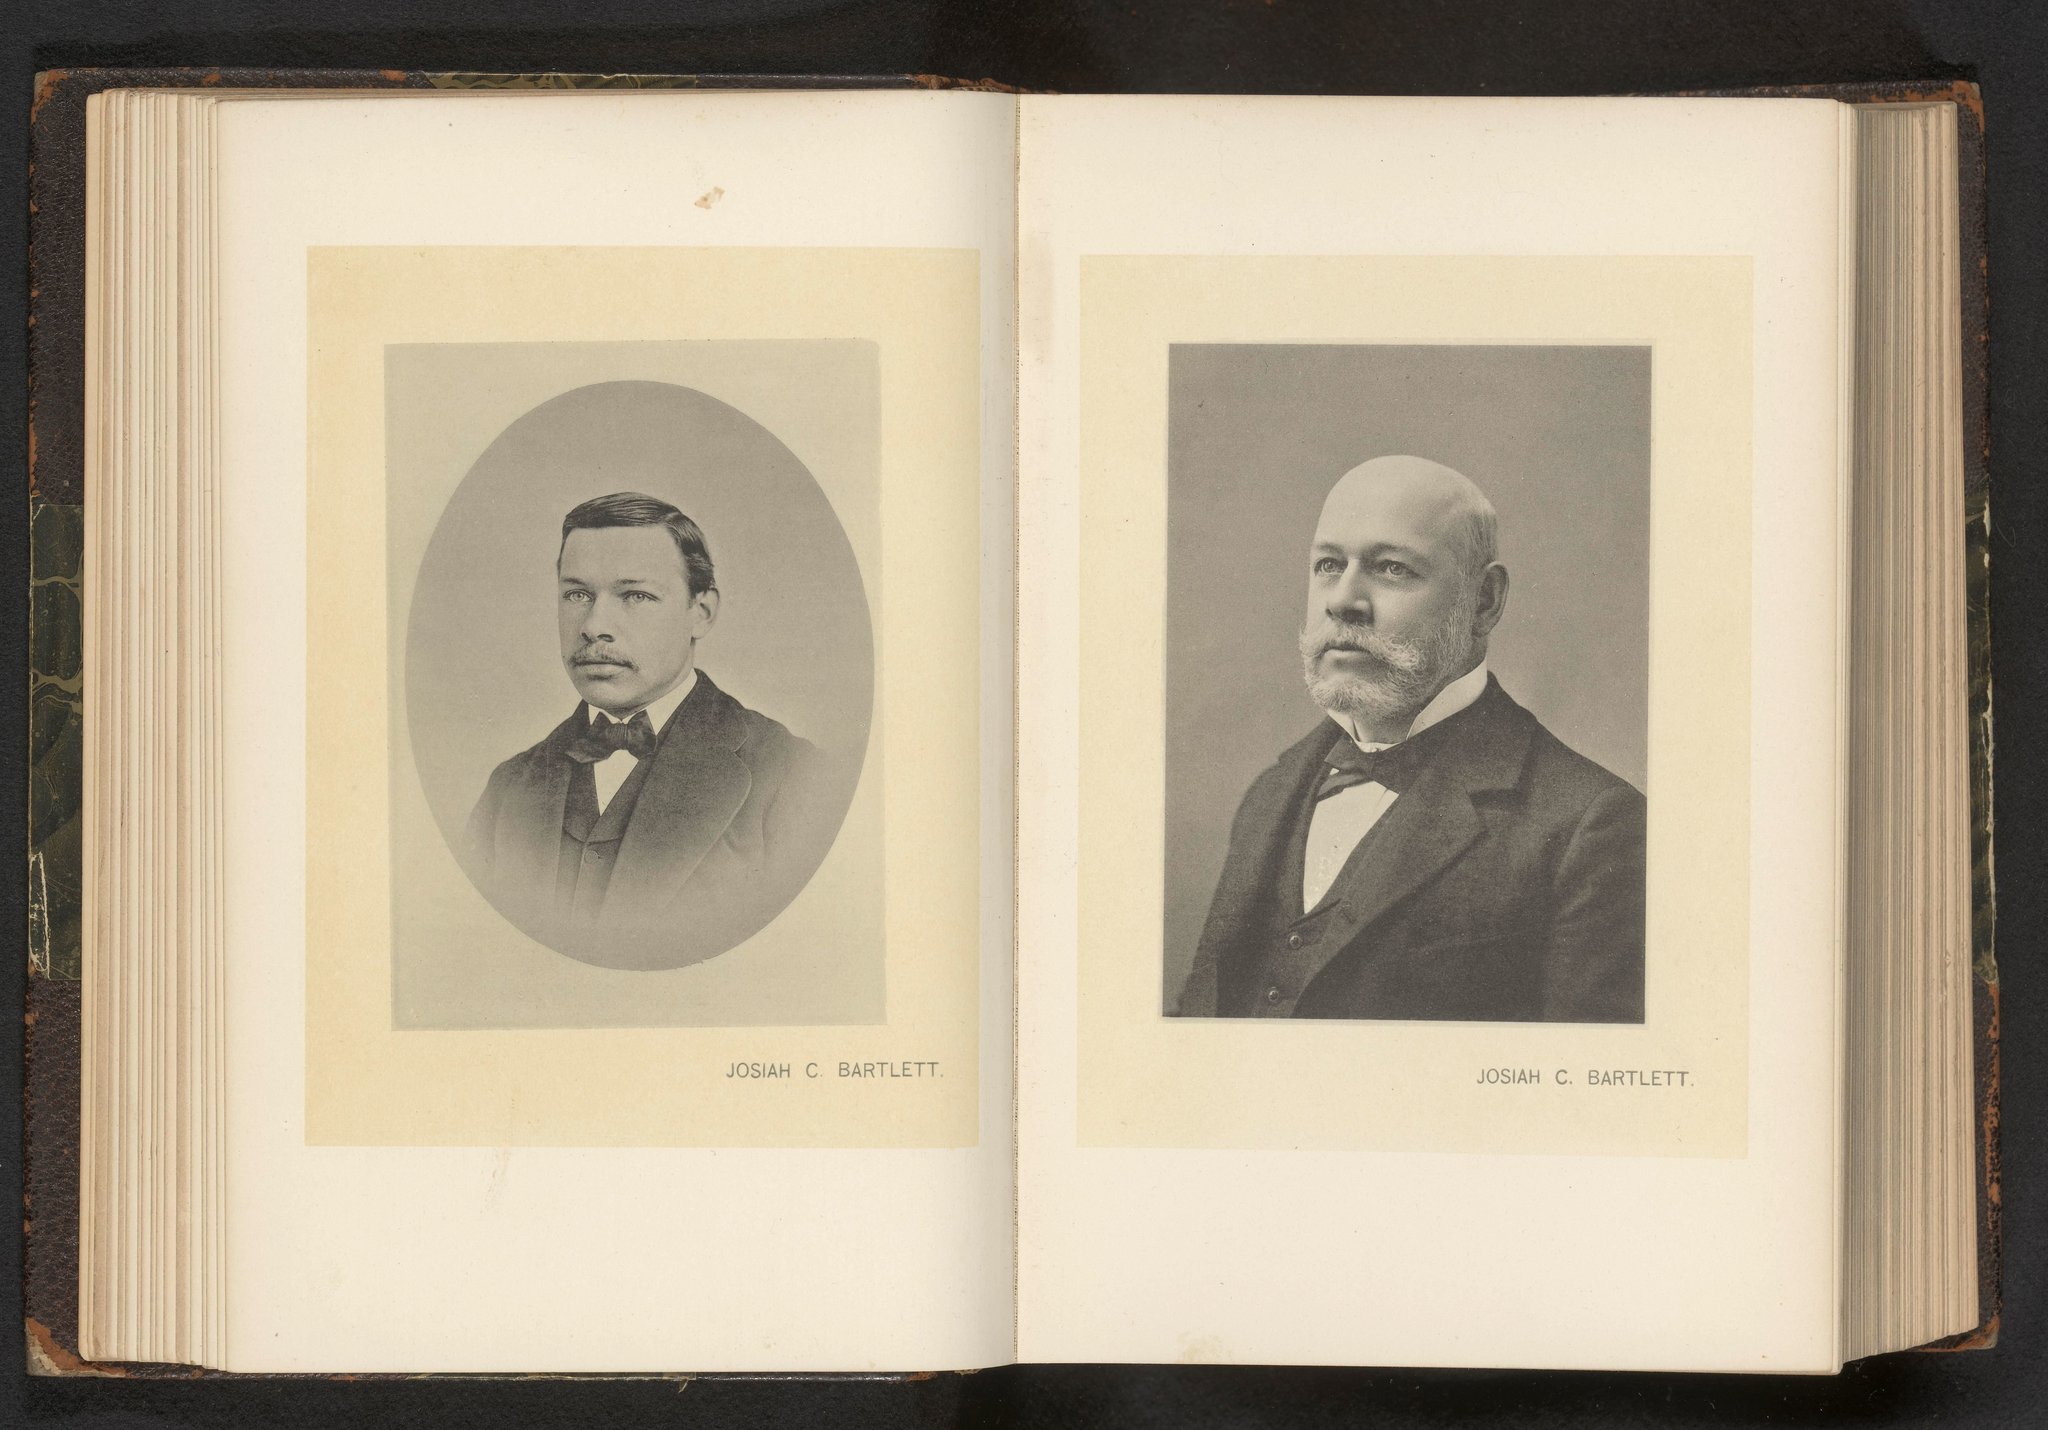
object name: photomechanical print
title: Josiah C. Bartlett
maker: Anonymous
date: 1869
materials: paper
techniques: photoaquatint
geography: boston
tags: adult man